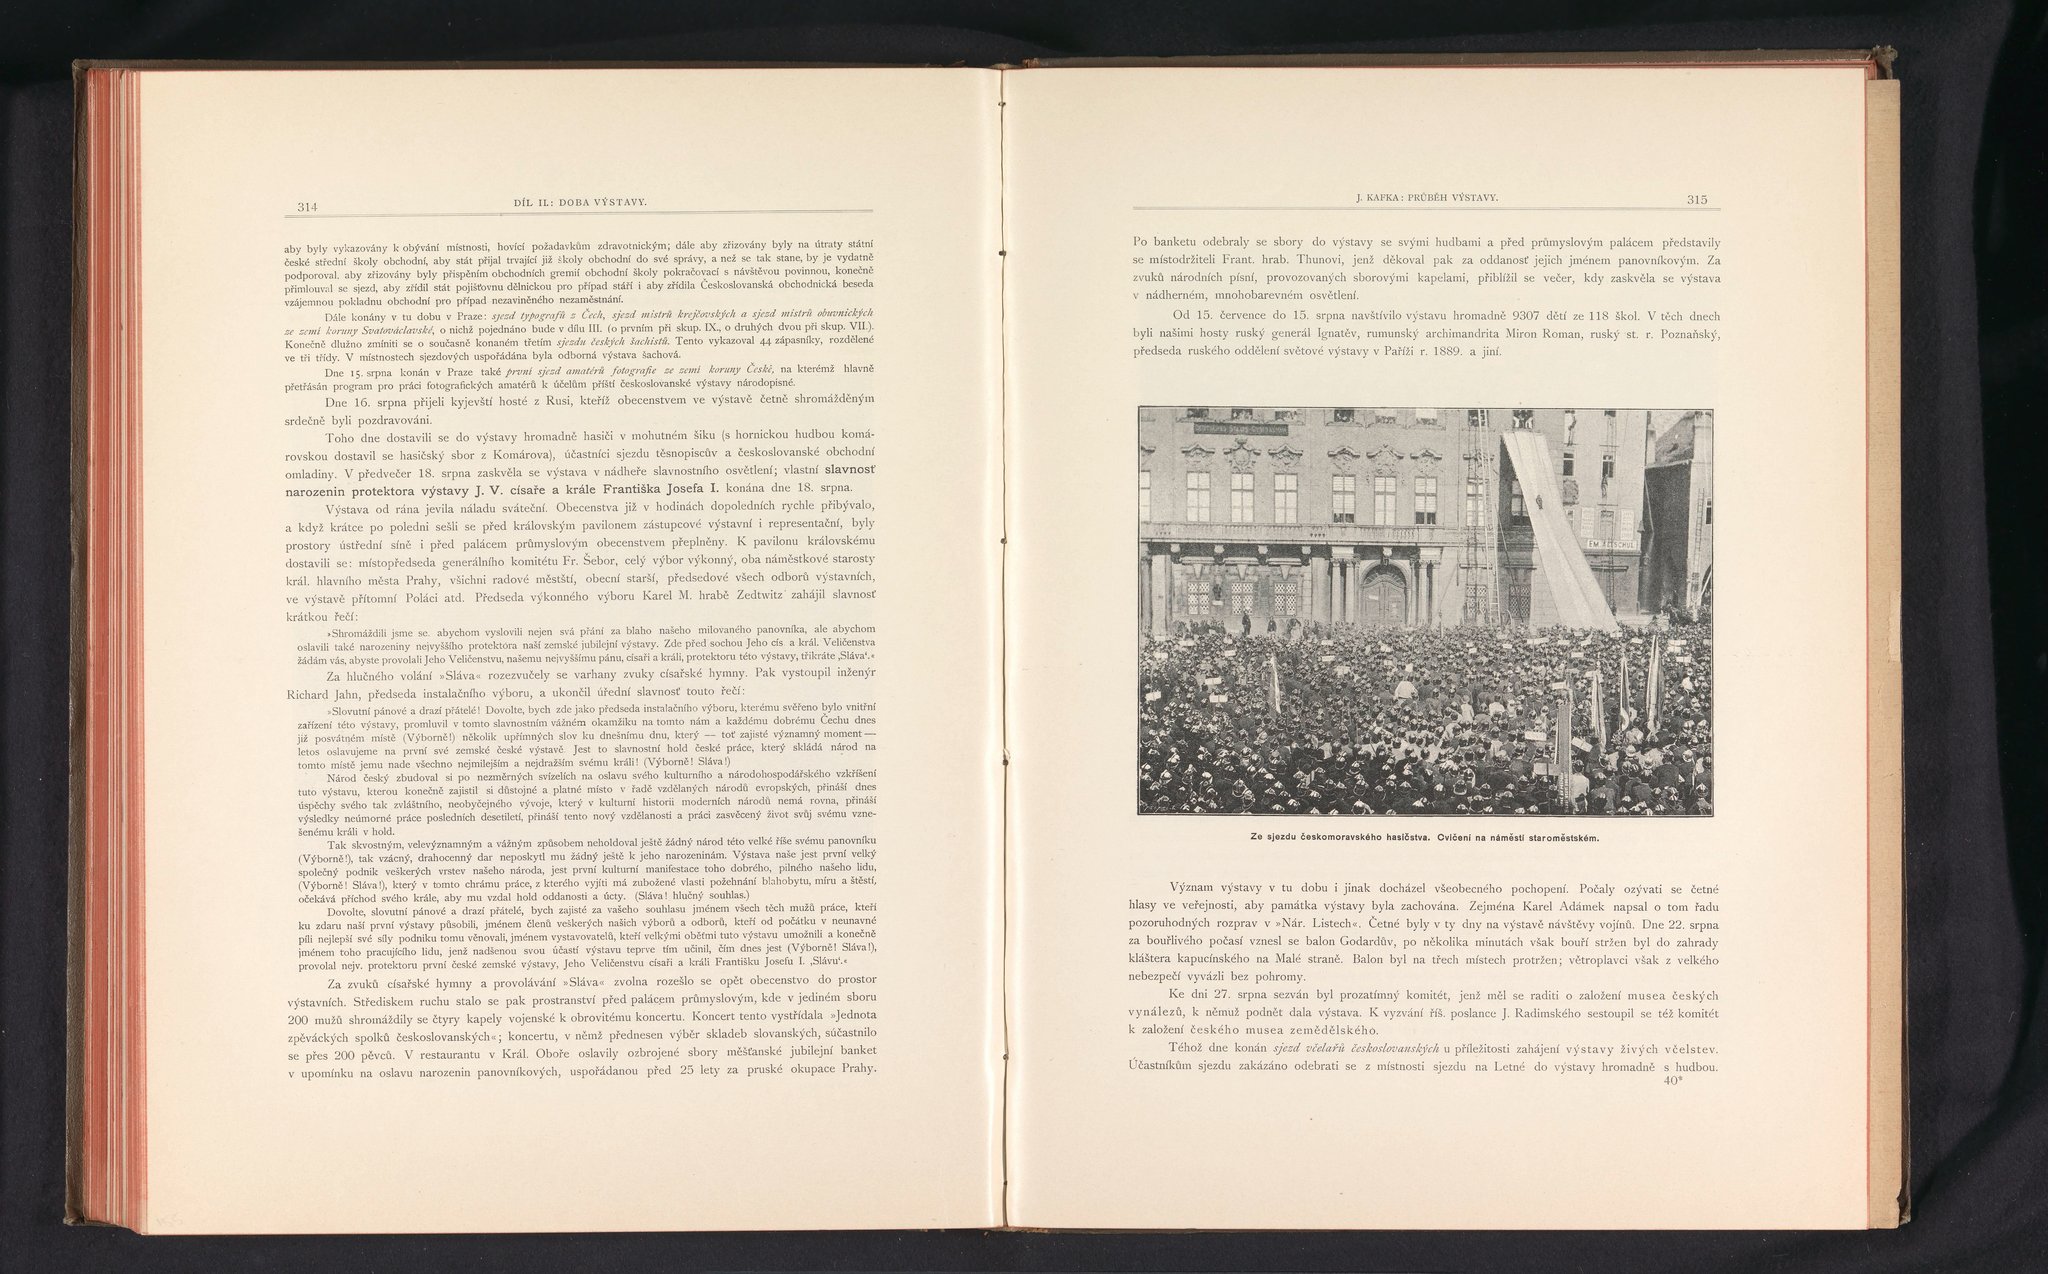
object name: page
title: Demonstratie van Tsjechisch-Moravische brandweerlieden op het Staroměstské náměstí te Praag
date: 1891-1893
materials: paper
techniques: autotype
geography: prague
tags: firemen, village square, place